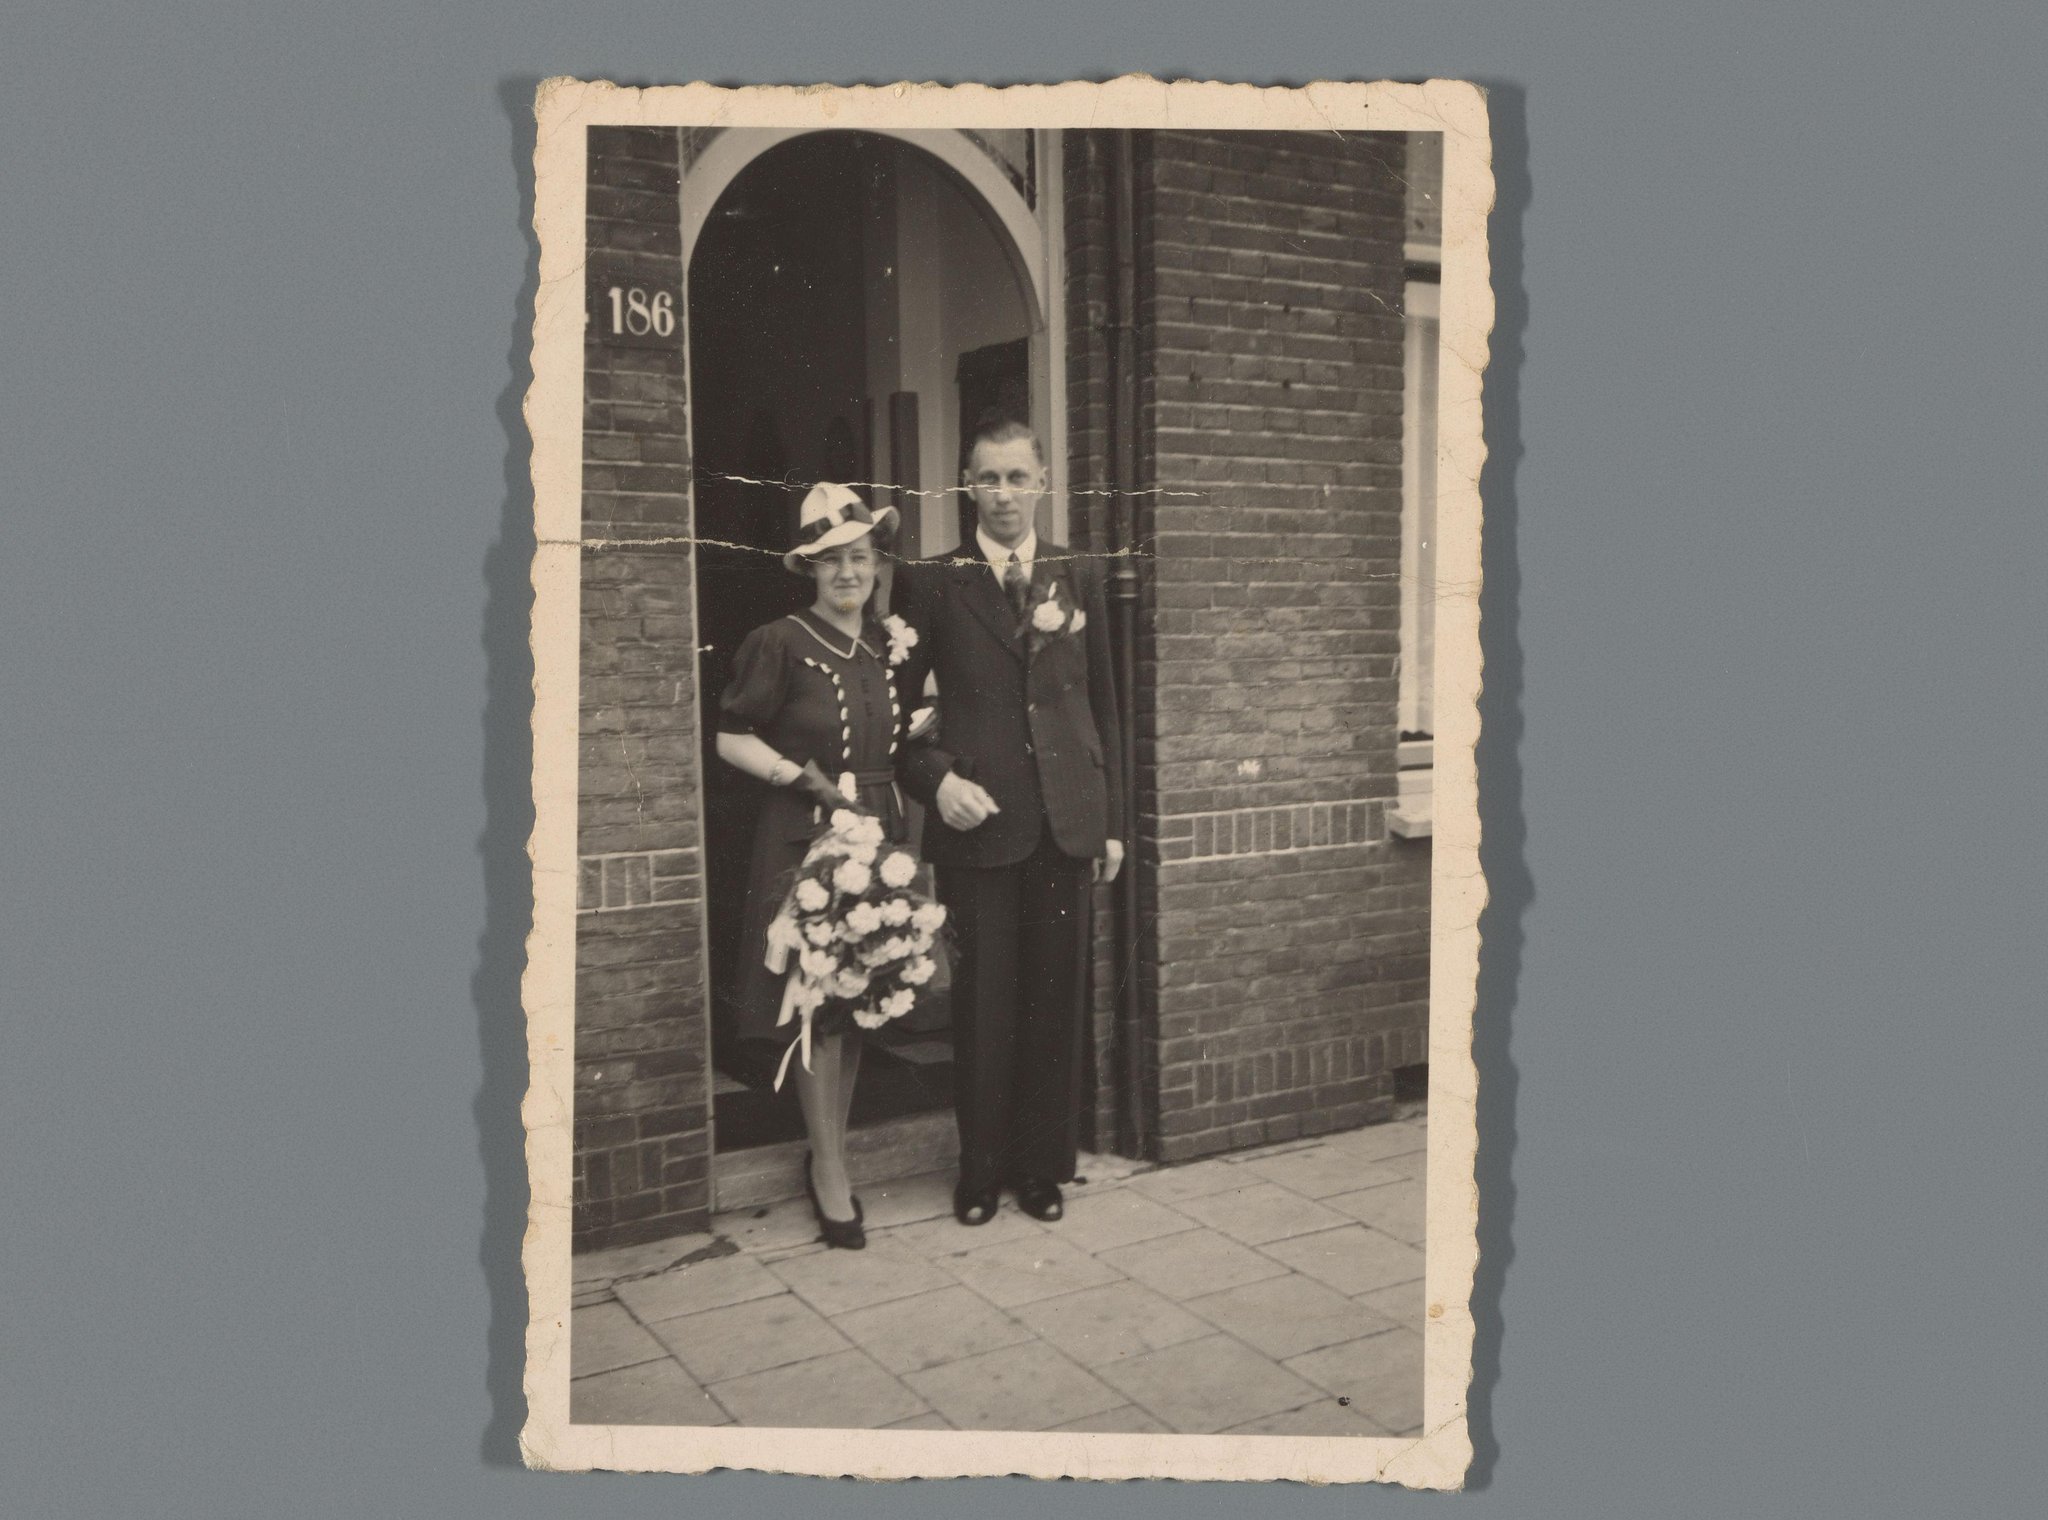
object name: photograph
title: Portret van een onbekend echtpaar, staande in een deuropening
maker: Anonymous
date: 1930-1940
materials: paper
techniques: gelatin silver print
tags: anonymous historical persons portrayed in a double portrait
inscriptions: number: ‘867’